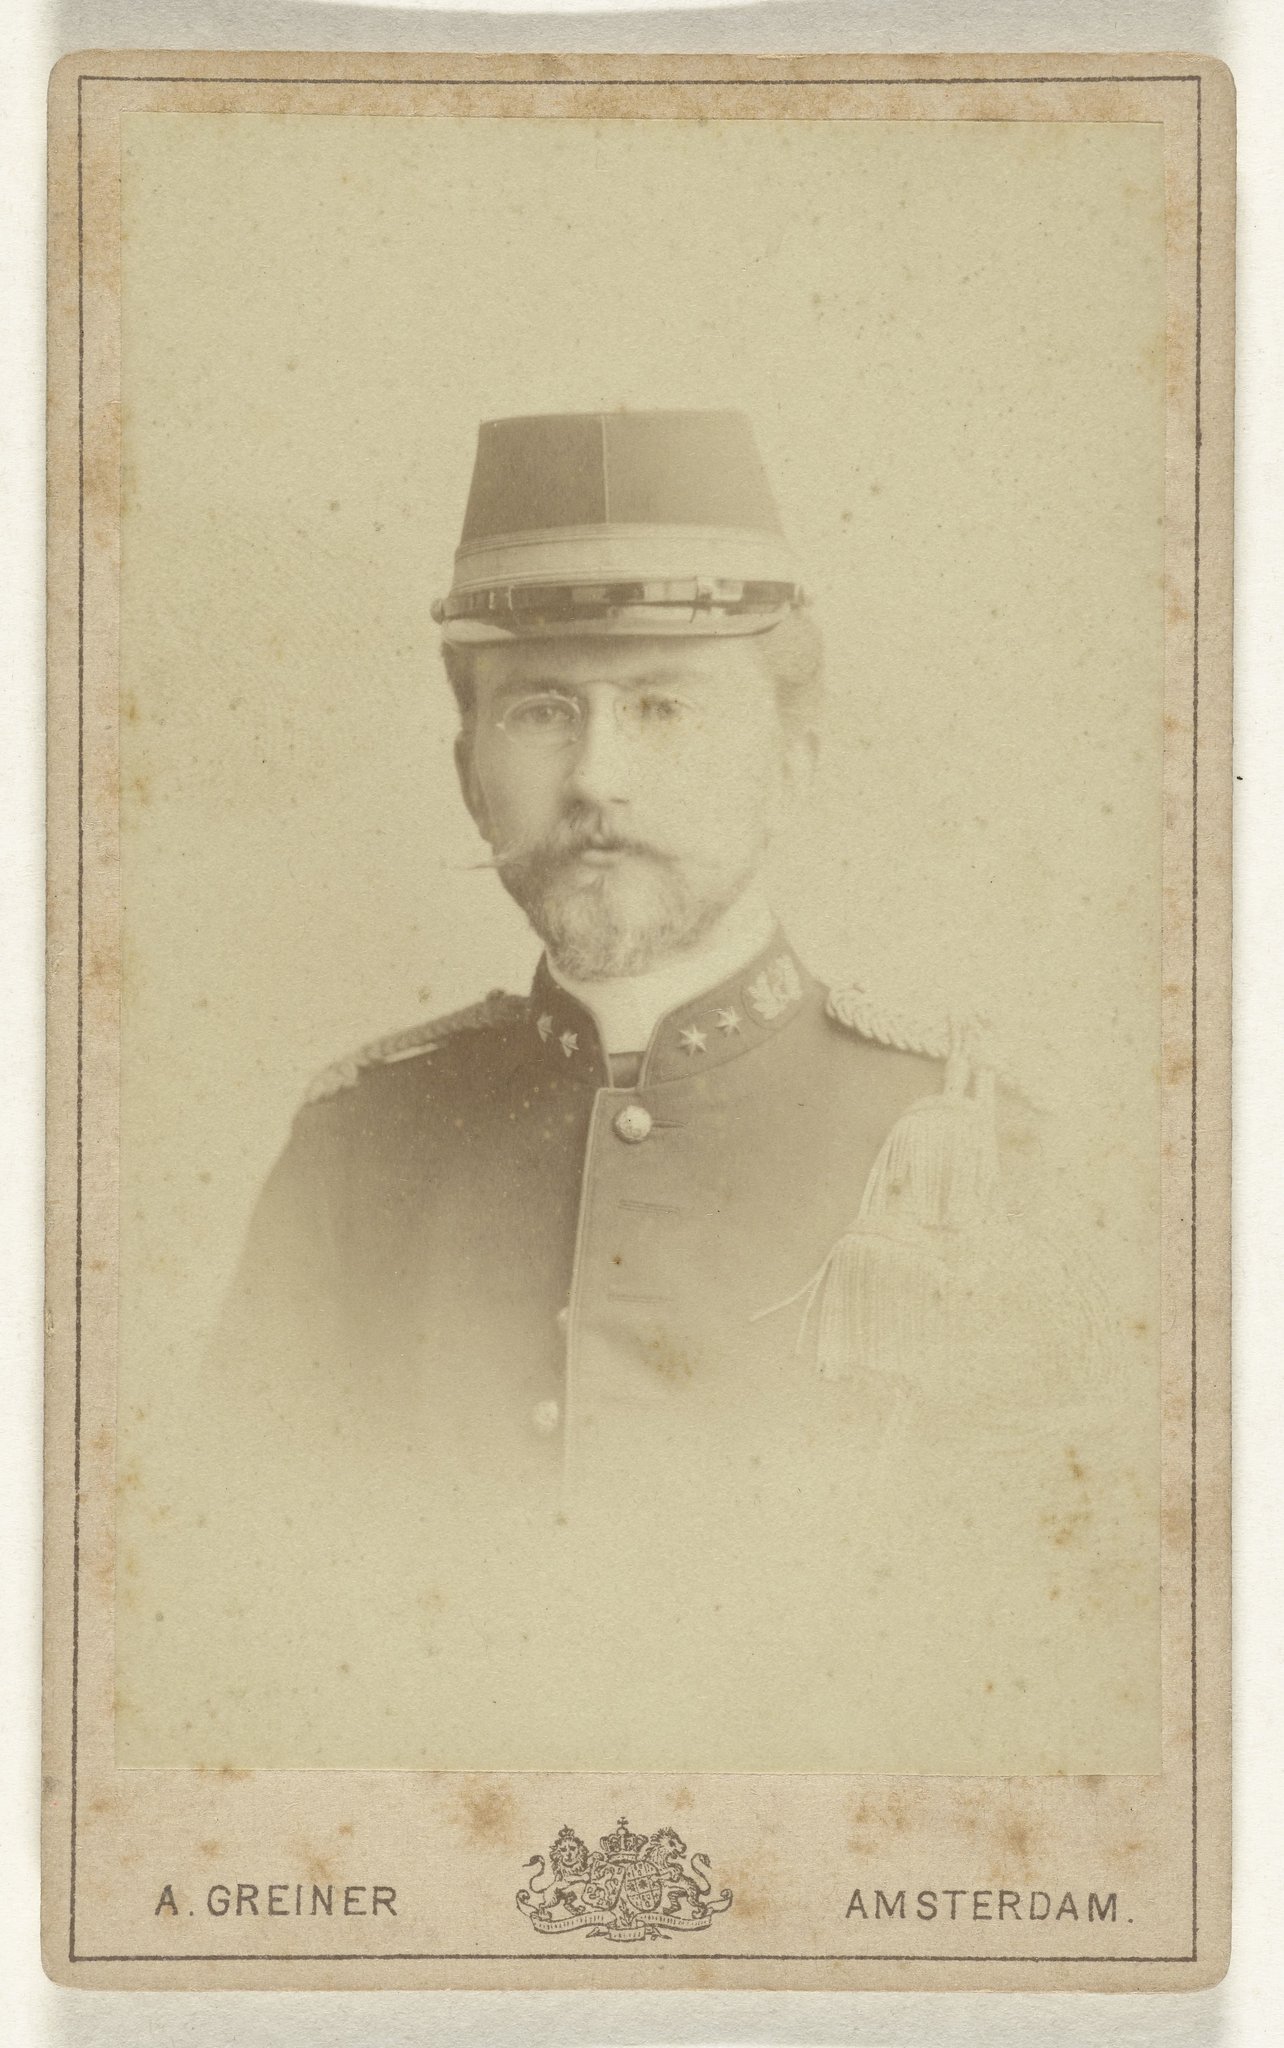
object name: carte de visite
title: Studioportret van een man met snor, baard en bril in leger uniform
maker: albert greiner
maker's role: fotograaf, fotostudio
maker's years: 1833-1890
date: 1890-1915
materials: paper, photographic support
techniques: photography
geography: amsterdam